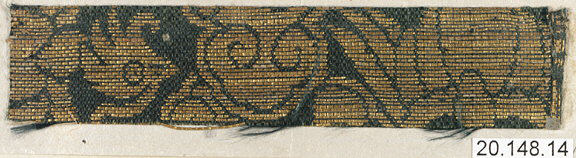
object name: piece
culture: japanese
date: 1301-1400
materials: silk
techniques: compound weave